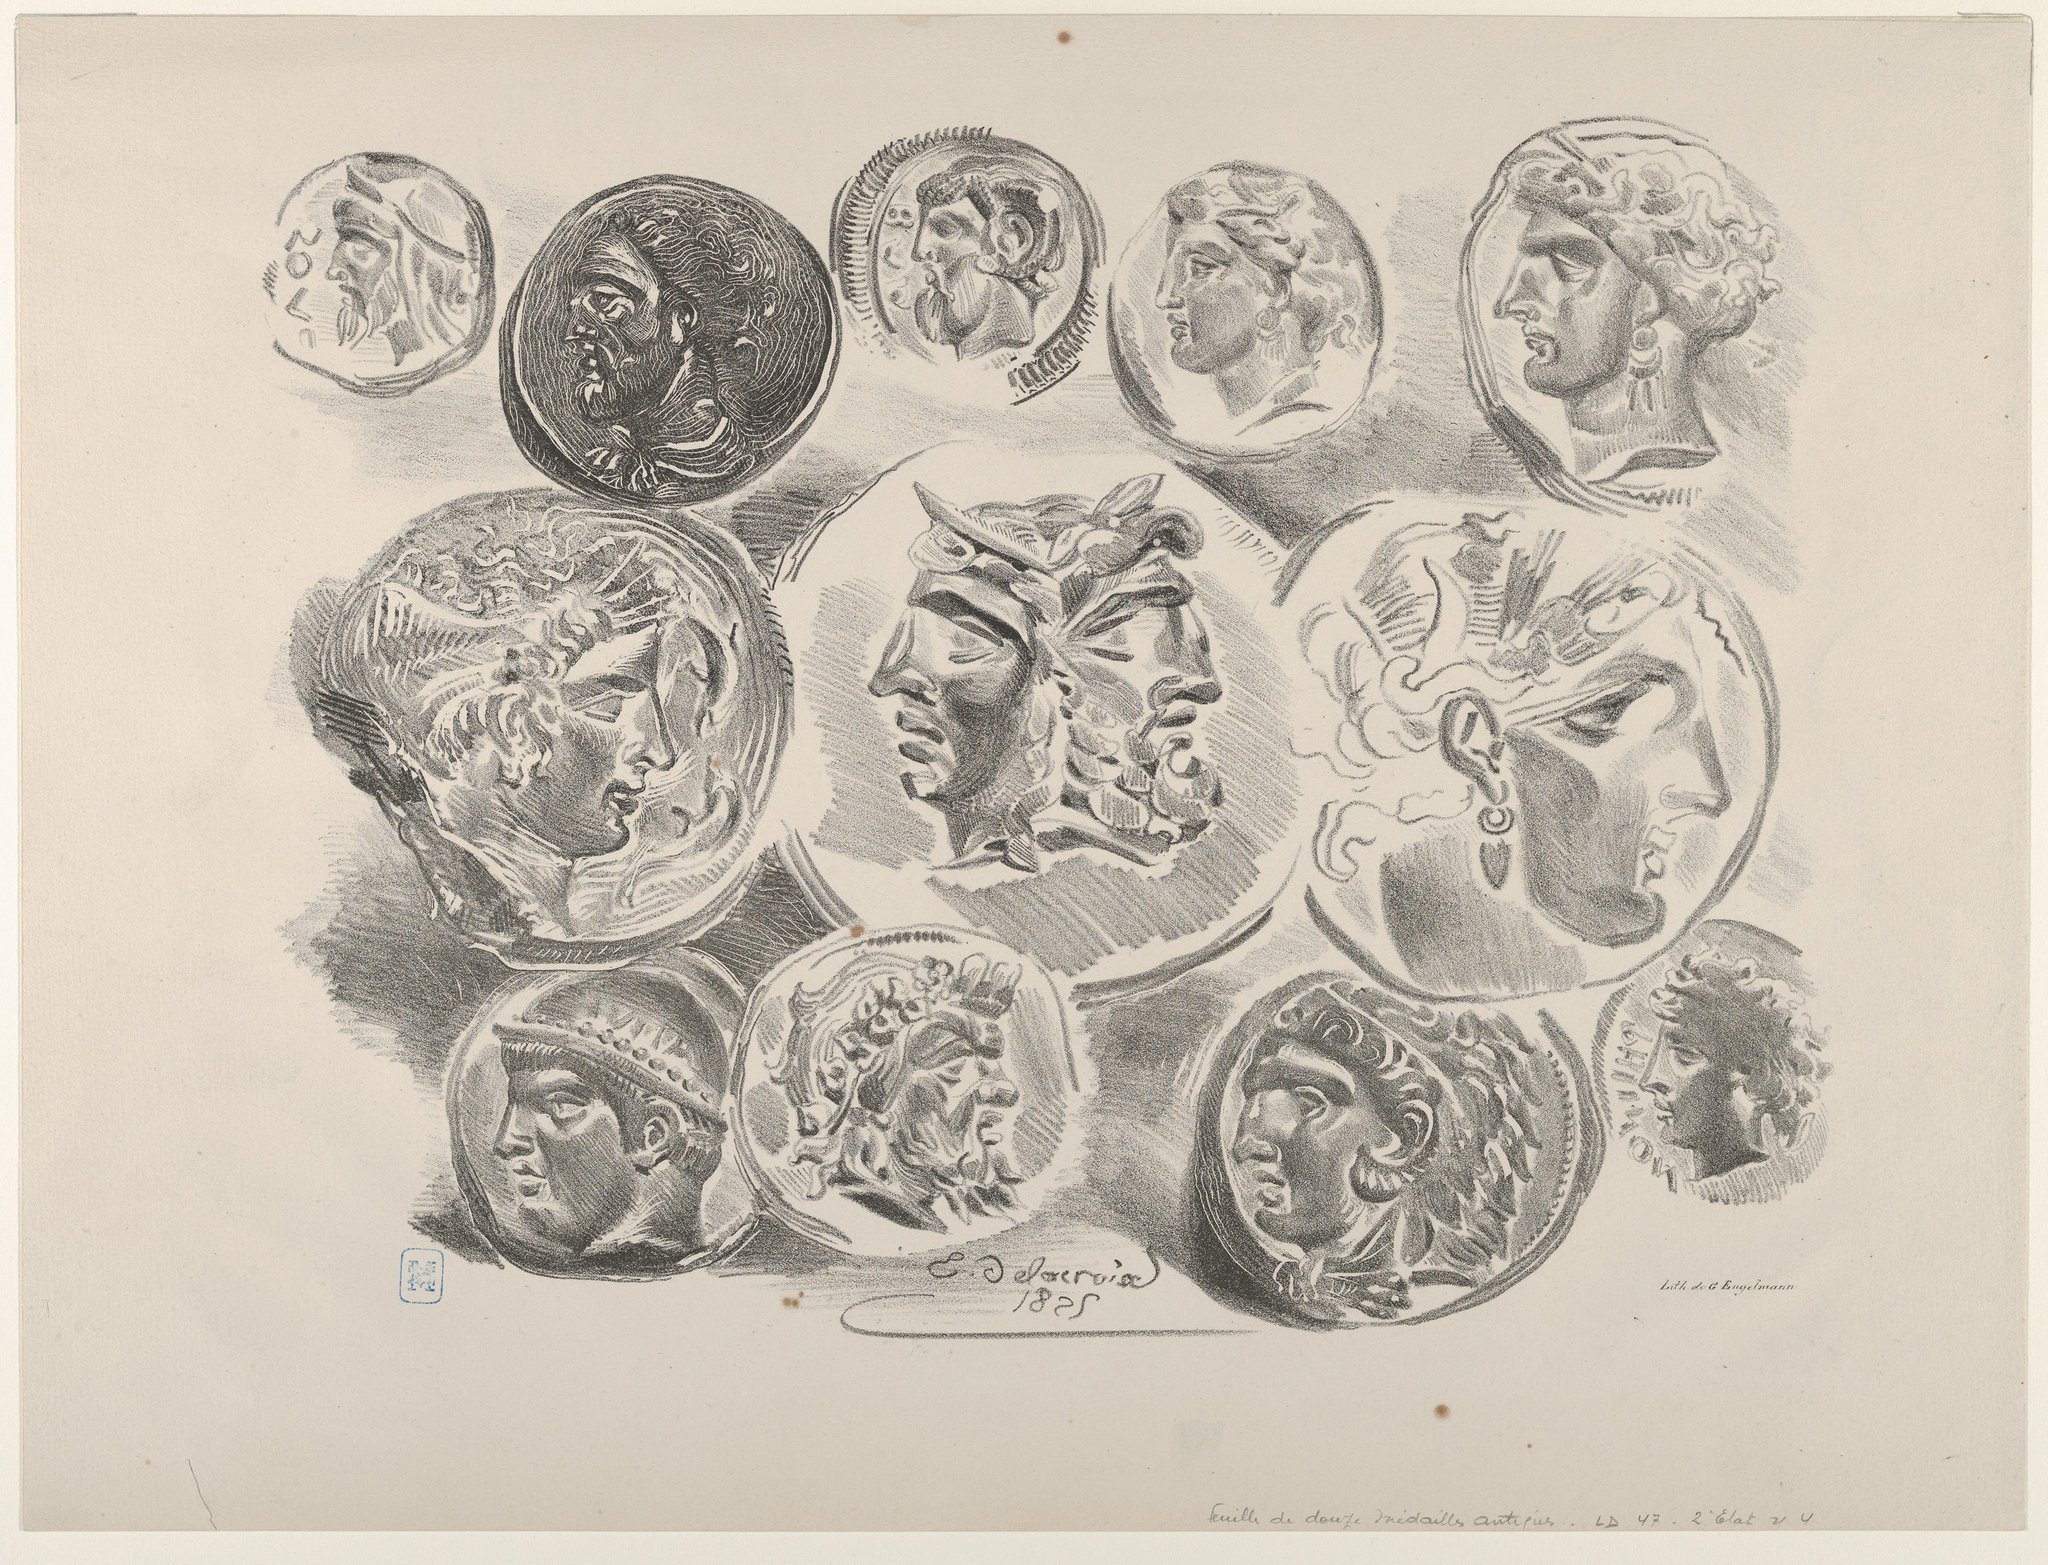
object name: print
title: Studies of Twelve Greek and Roman Coins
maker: eugène delacroix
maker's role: artist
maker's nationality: french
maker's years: 1798-1863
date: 1825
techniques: lithograph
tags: men,profiles,women,coins